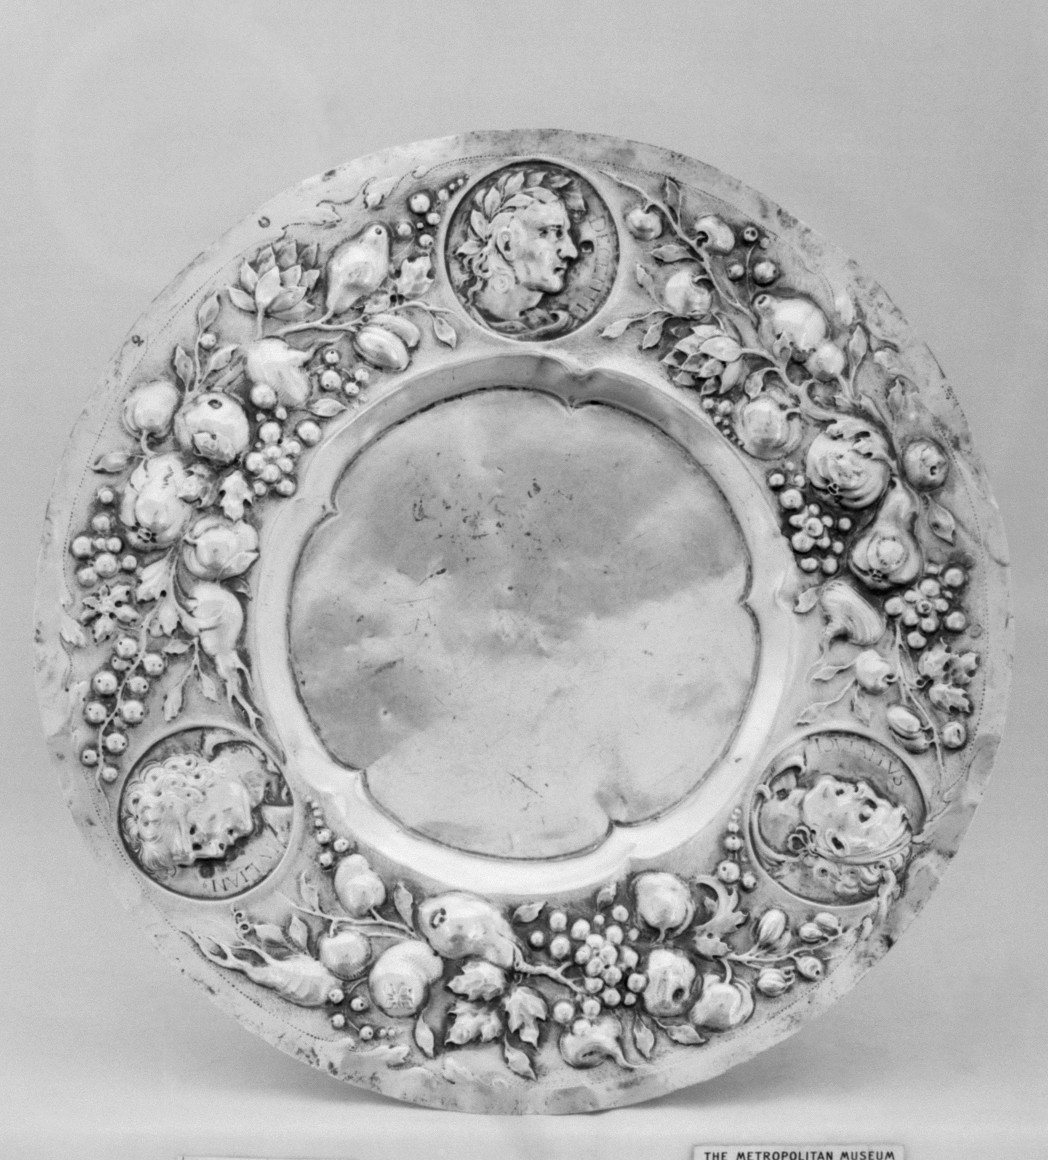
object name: plate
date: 1690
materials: silver gilt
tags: fruit,men,profiles,flowers